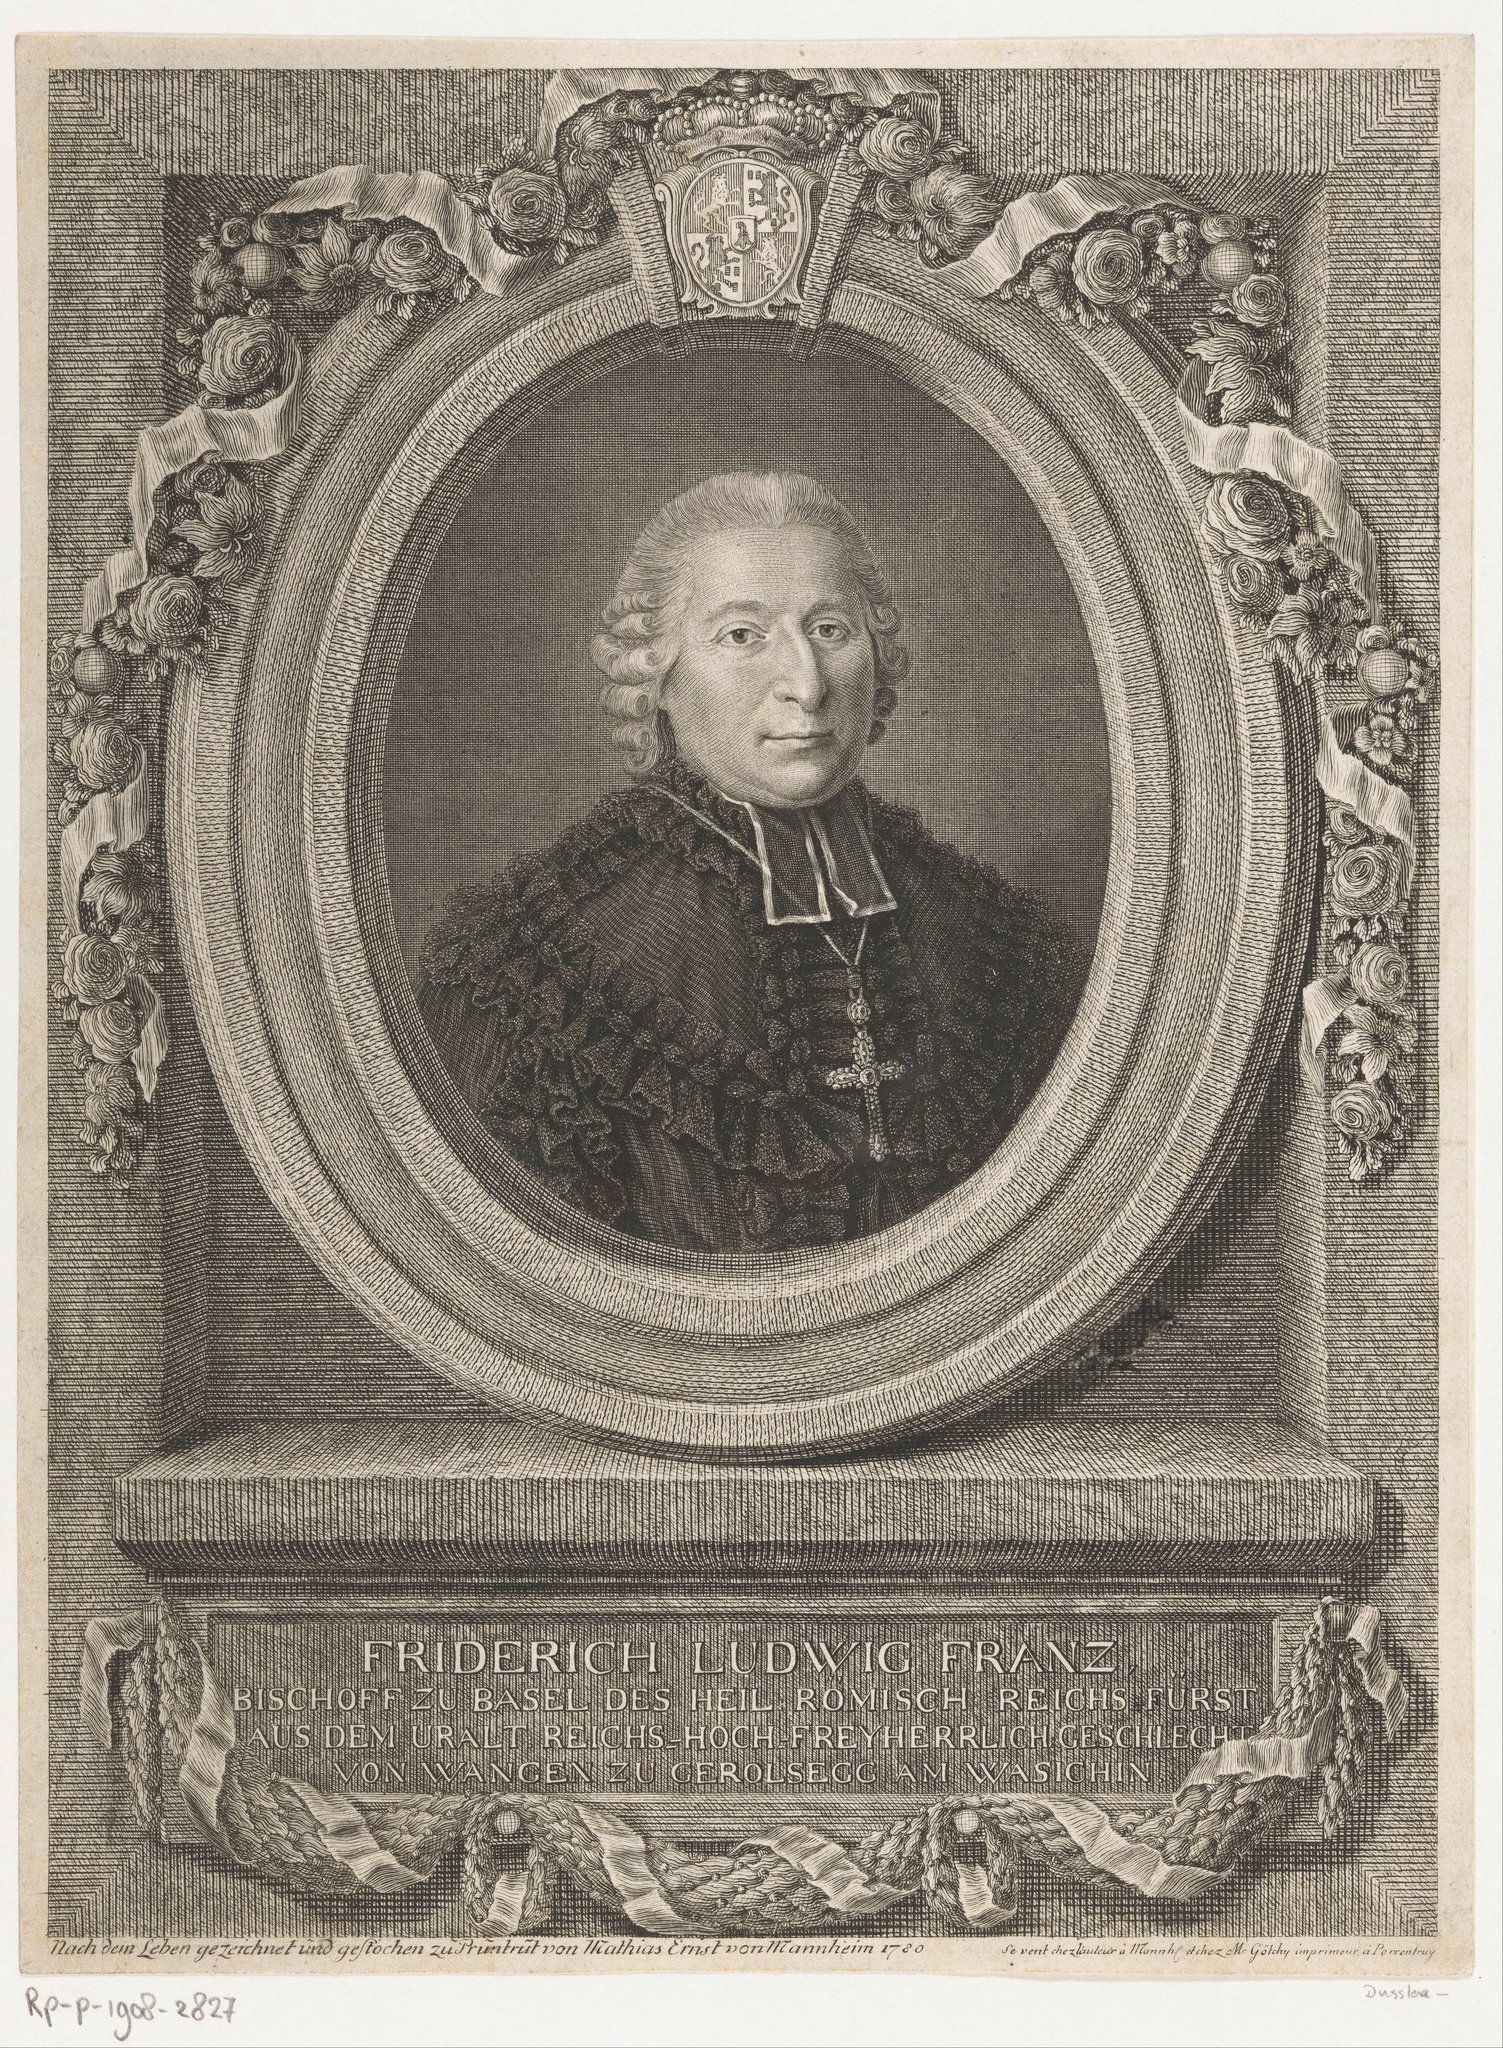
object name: print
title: Portret van Friedrich Ludwig Franz von Wangen zu Geroldseck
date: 1780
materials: paper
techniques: engraving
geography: mannheim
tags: archbishop, bishop, etc. (roman catholic), historical persons, crucifix ~ personal devotion, ornament ~ festoon, garland, armorial bearing, heraldry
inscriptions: collector's mark: Lugt 2228